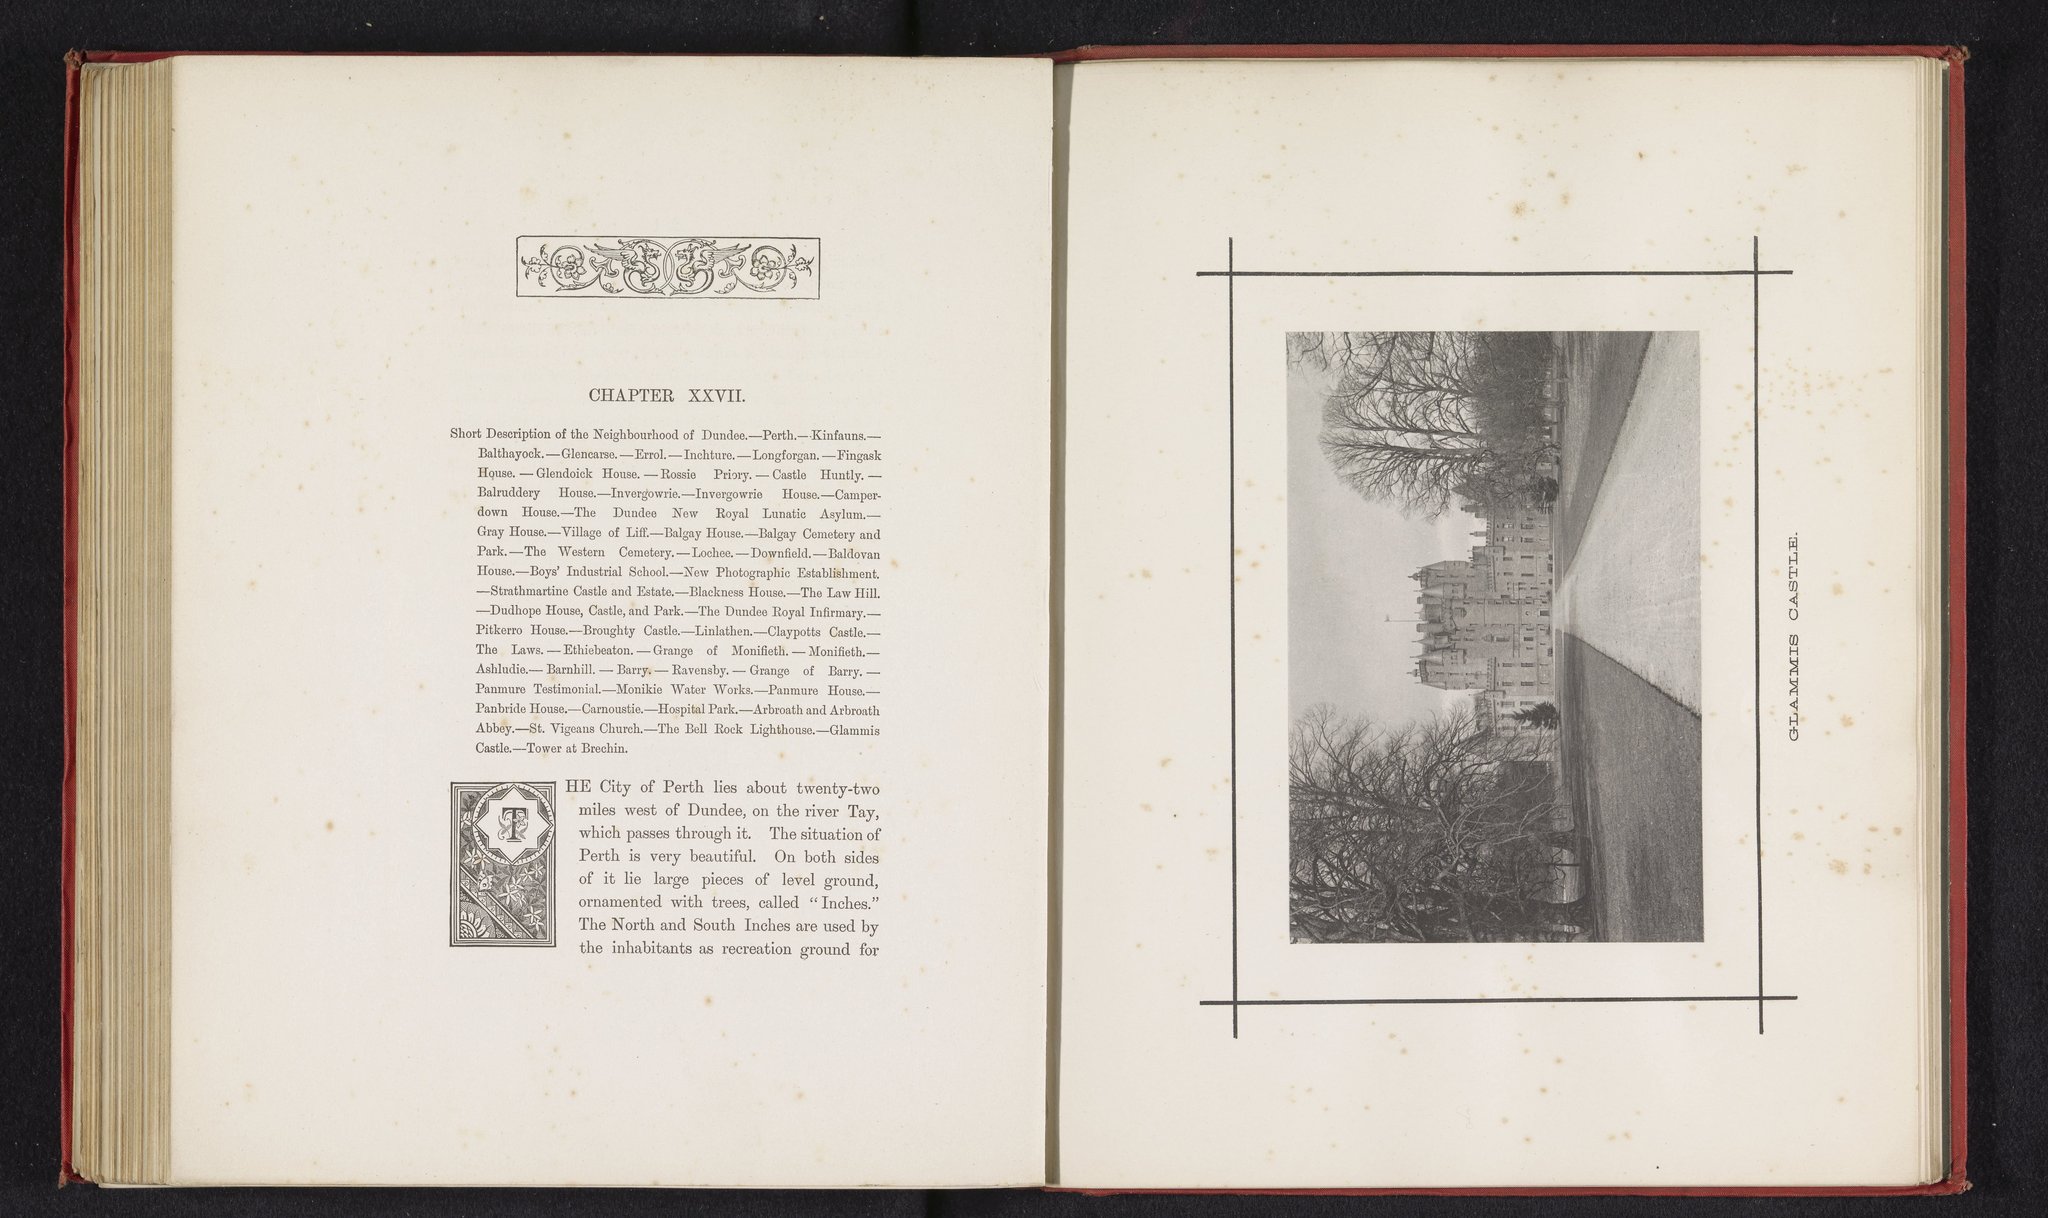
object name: page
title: GLAMMIS CASTLE.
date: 1880-1890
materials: photographic support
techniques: platinum process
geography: glamis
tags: castle